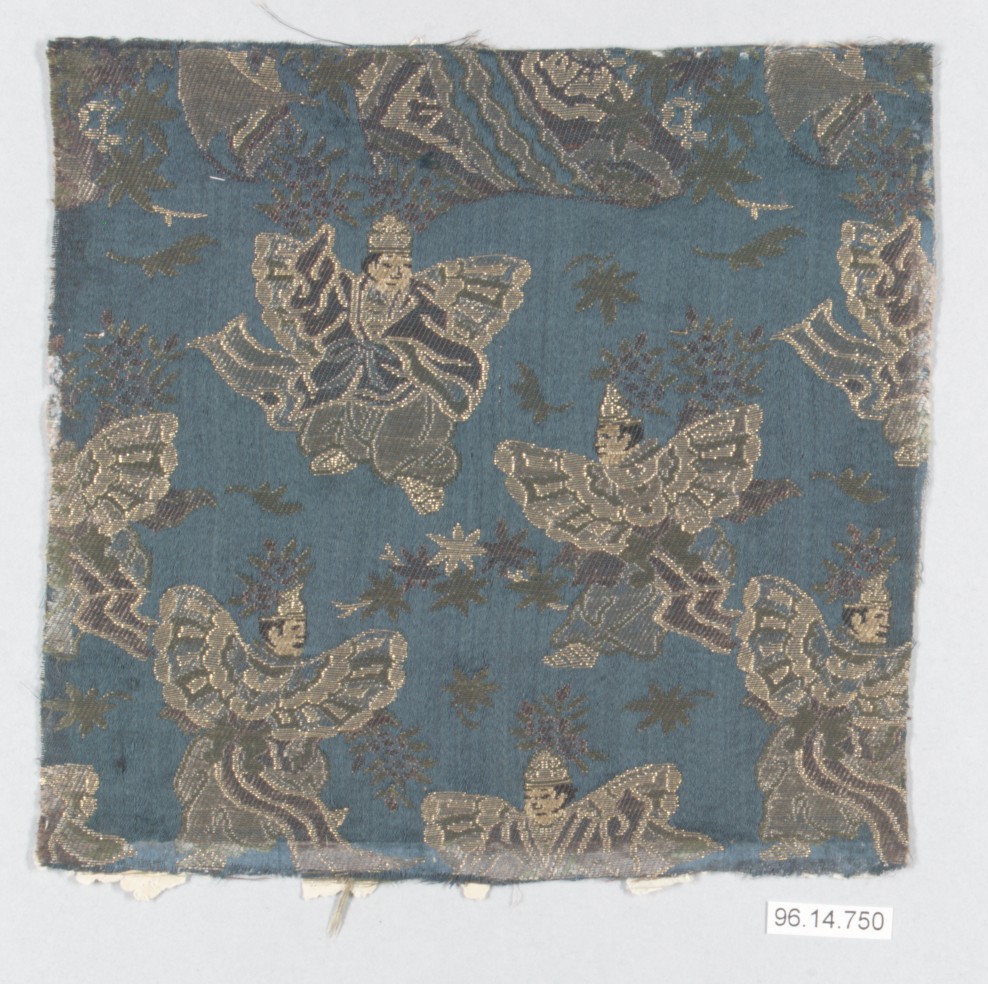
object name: piece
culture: japanese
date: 1801-1900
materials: metal thread, silk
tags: human figures